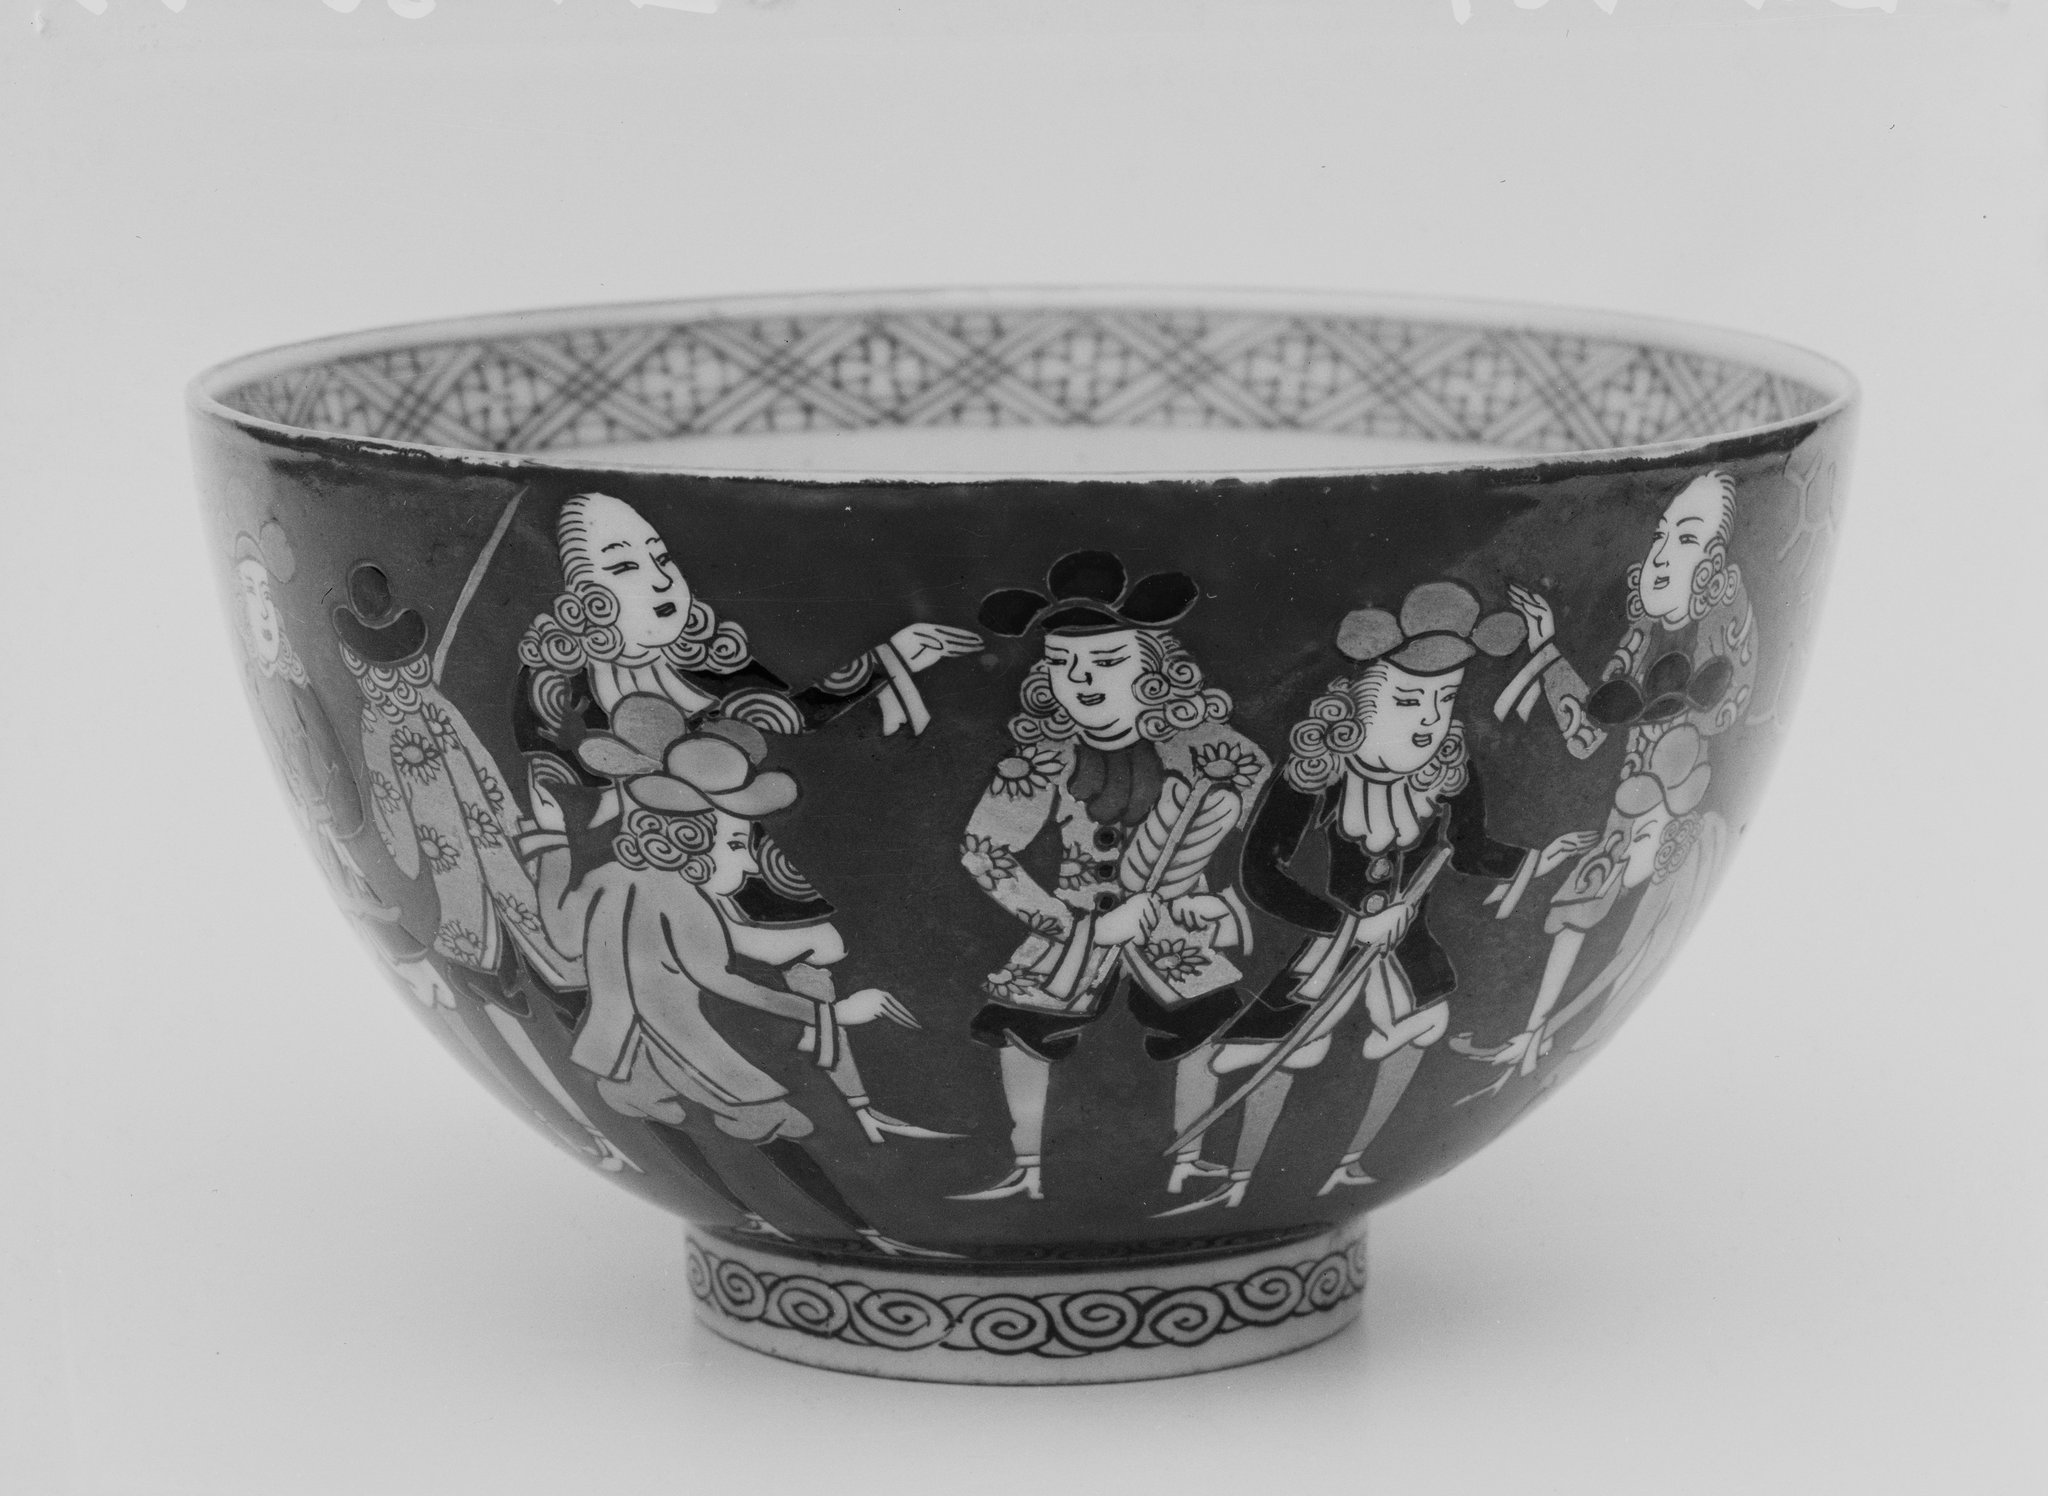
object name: bowl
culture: japanese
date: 1767-1900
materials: porcelain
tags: men